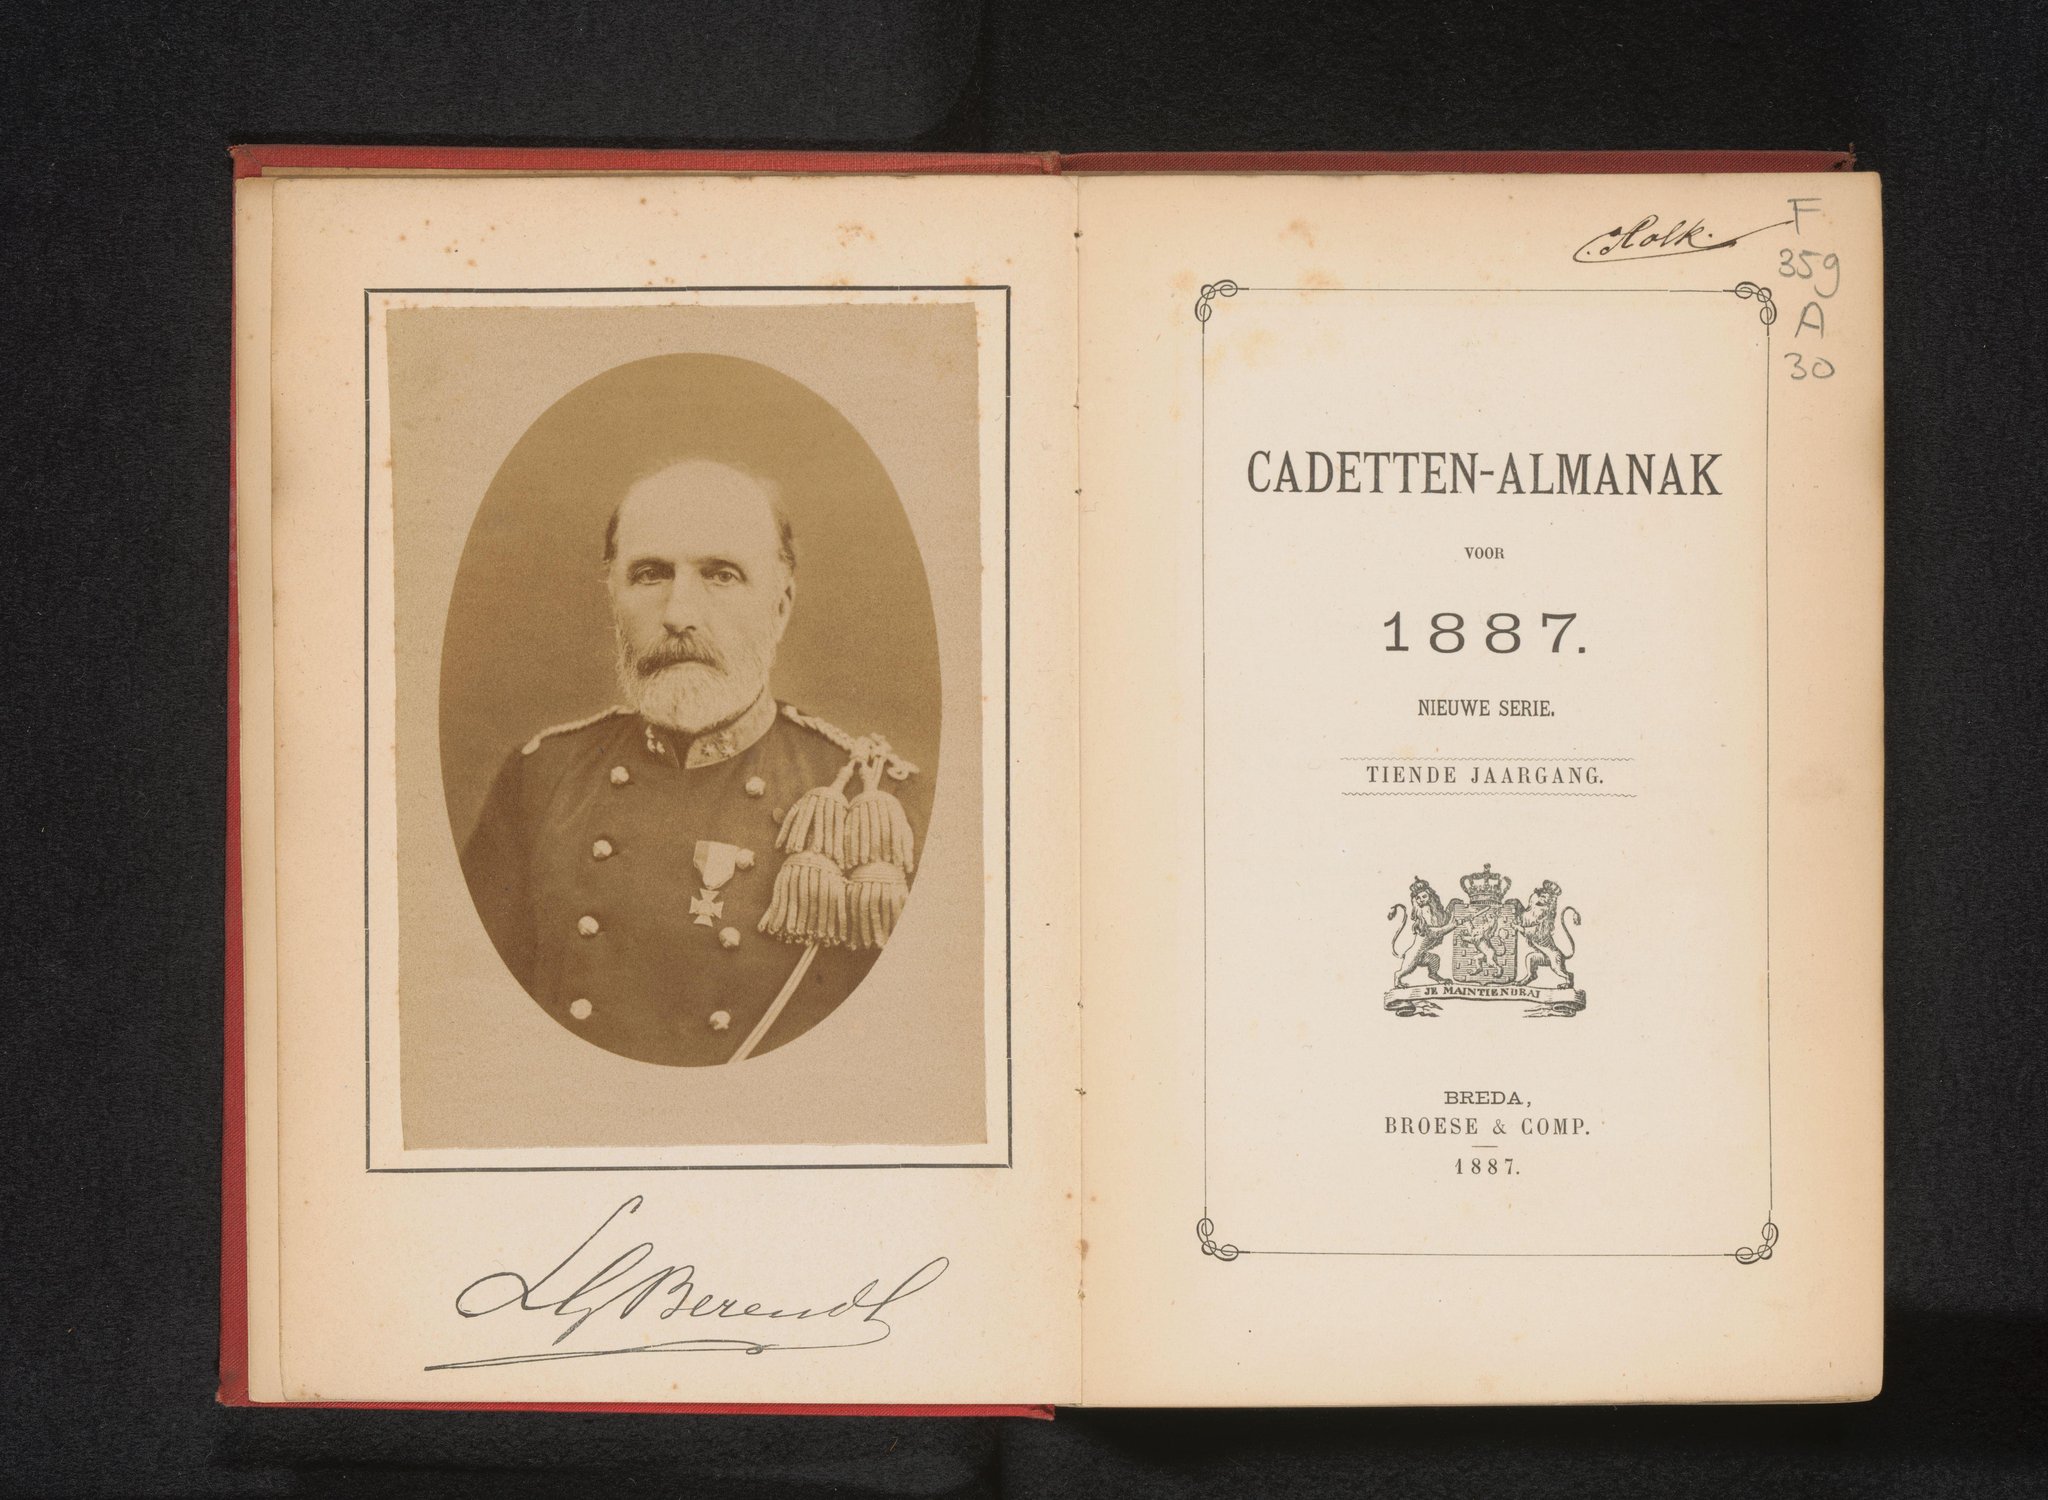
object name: photograph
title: Portret van kolonel L.G. Berends, oud gouverneur van de Koninklijke Militaire Academie in Breda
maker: Anonymous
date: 1882-1887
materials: photographic support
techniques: albumen print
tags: historical persons, officer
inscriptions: signature: ‘L.G. Berends’